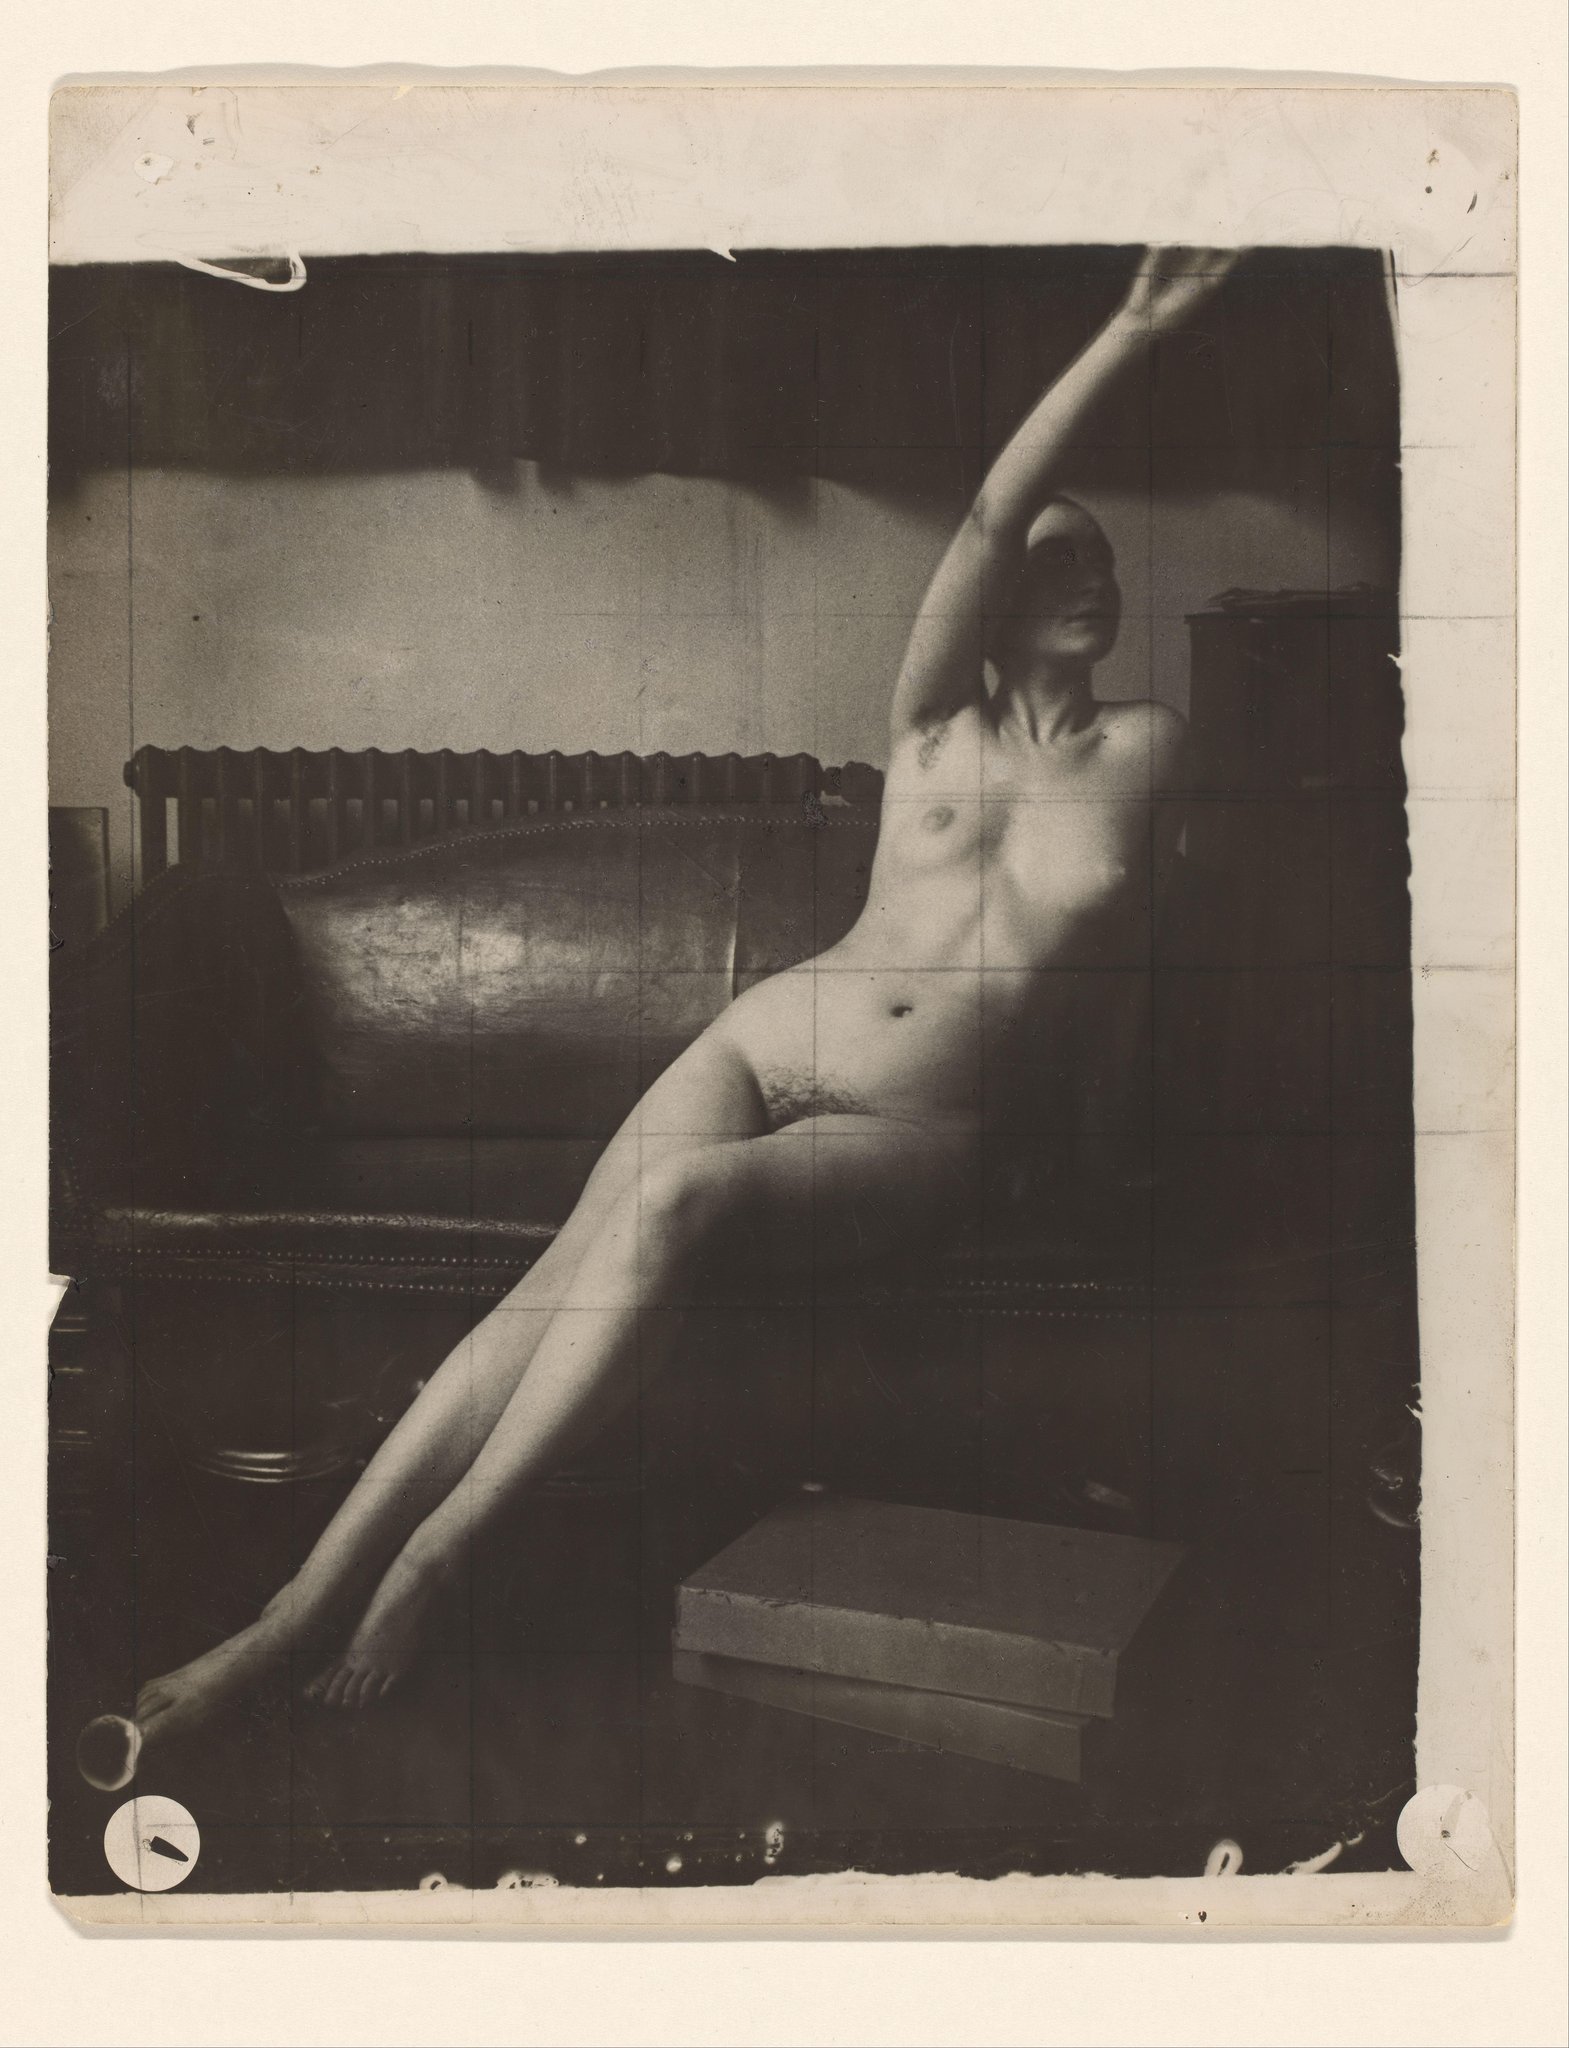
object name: photograph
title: Naaktstudie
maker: josep maria sert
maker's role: fotograaf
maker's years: 1874-1945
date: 1931-1932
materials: photographic support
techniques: gelatin silver print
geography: madrid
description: Naaktstudie L'Hommage á la maison d'Albe, Palacio de Liria, Madrid, van voren gezien. Voorstudie met quadratuur en punaisegaten in de hoeken.